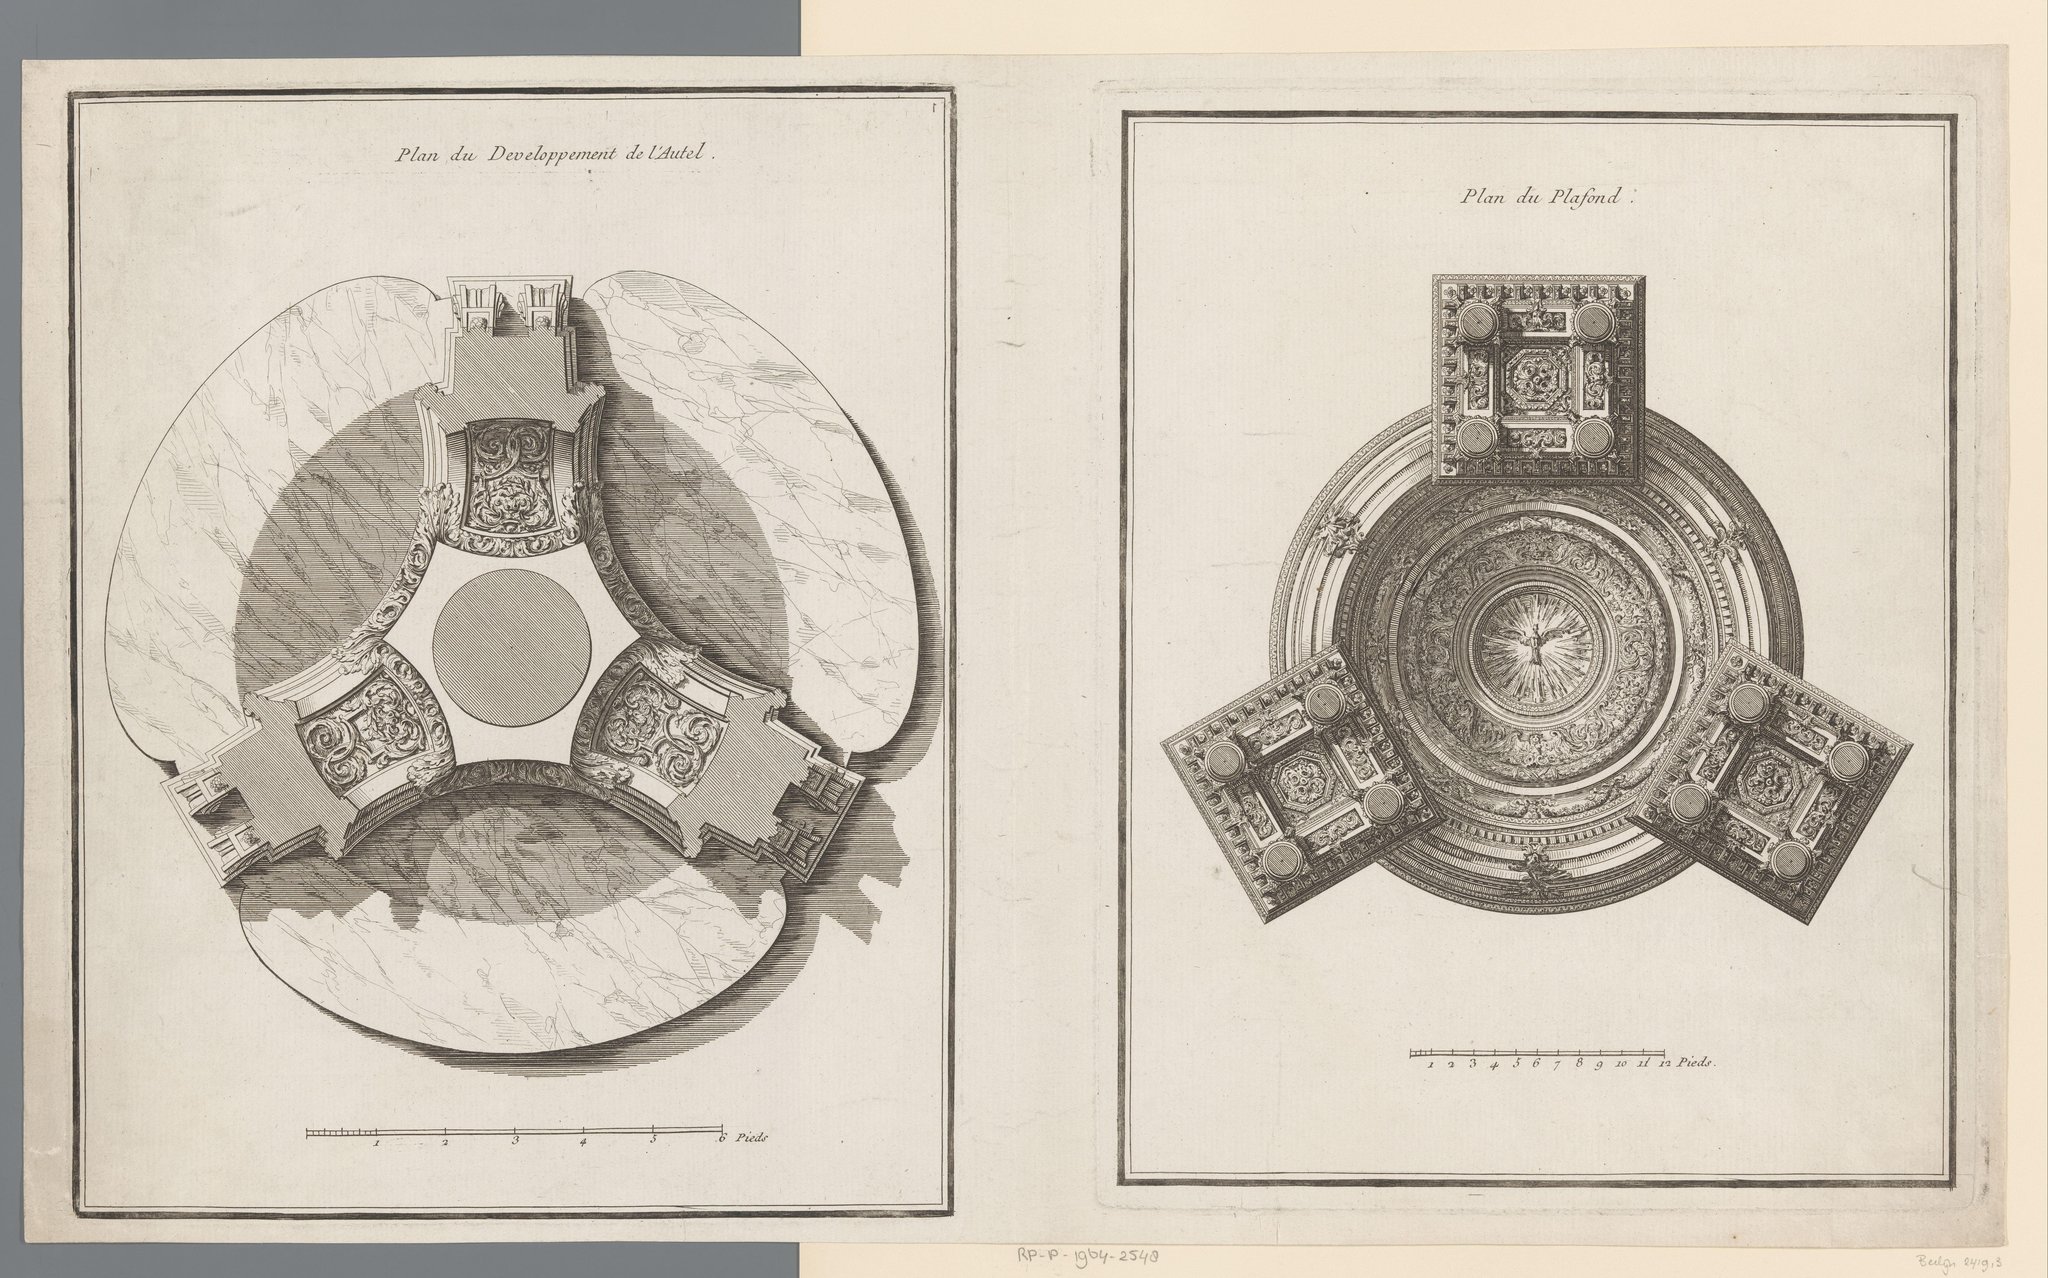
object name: ornament print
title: Ouvrage d'Architecture des Sieurs Deprez et Panseron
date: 1781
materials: paper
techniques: etching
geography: paris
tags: (decorated) ceiling, altar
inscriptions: collector's mark: Lugt 2228, collector's mark: Lugt 2760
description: Twee prenten op een blad. Links: Een bovenaanzicht van een altaar in driehoeksvorm gedecoreerd met acanthusmotieven. Rechts een rond plafond met drie vierkante elementen. In het midden een duif in stralenkrans als symbool van de Heilige Geest.